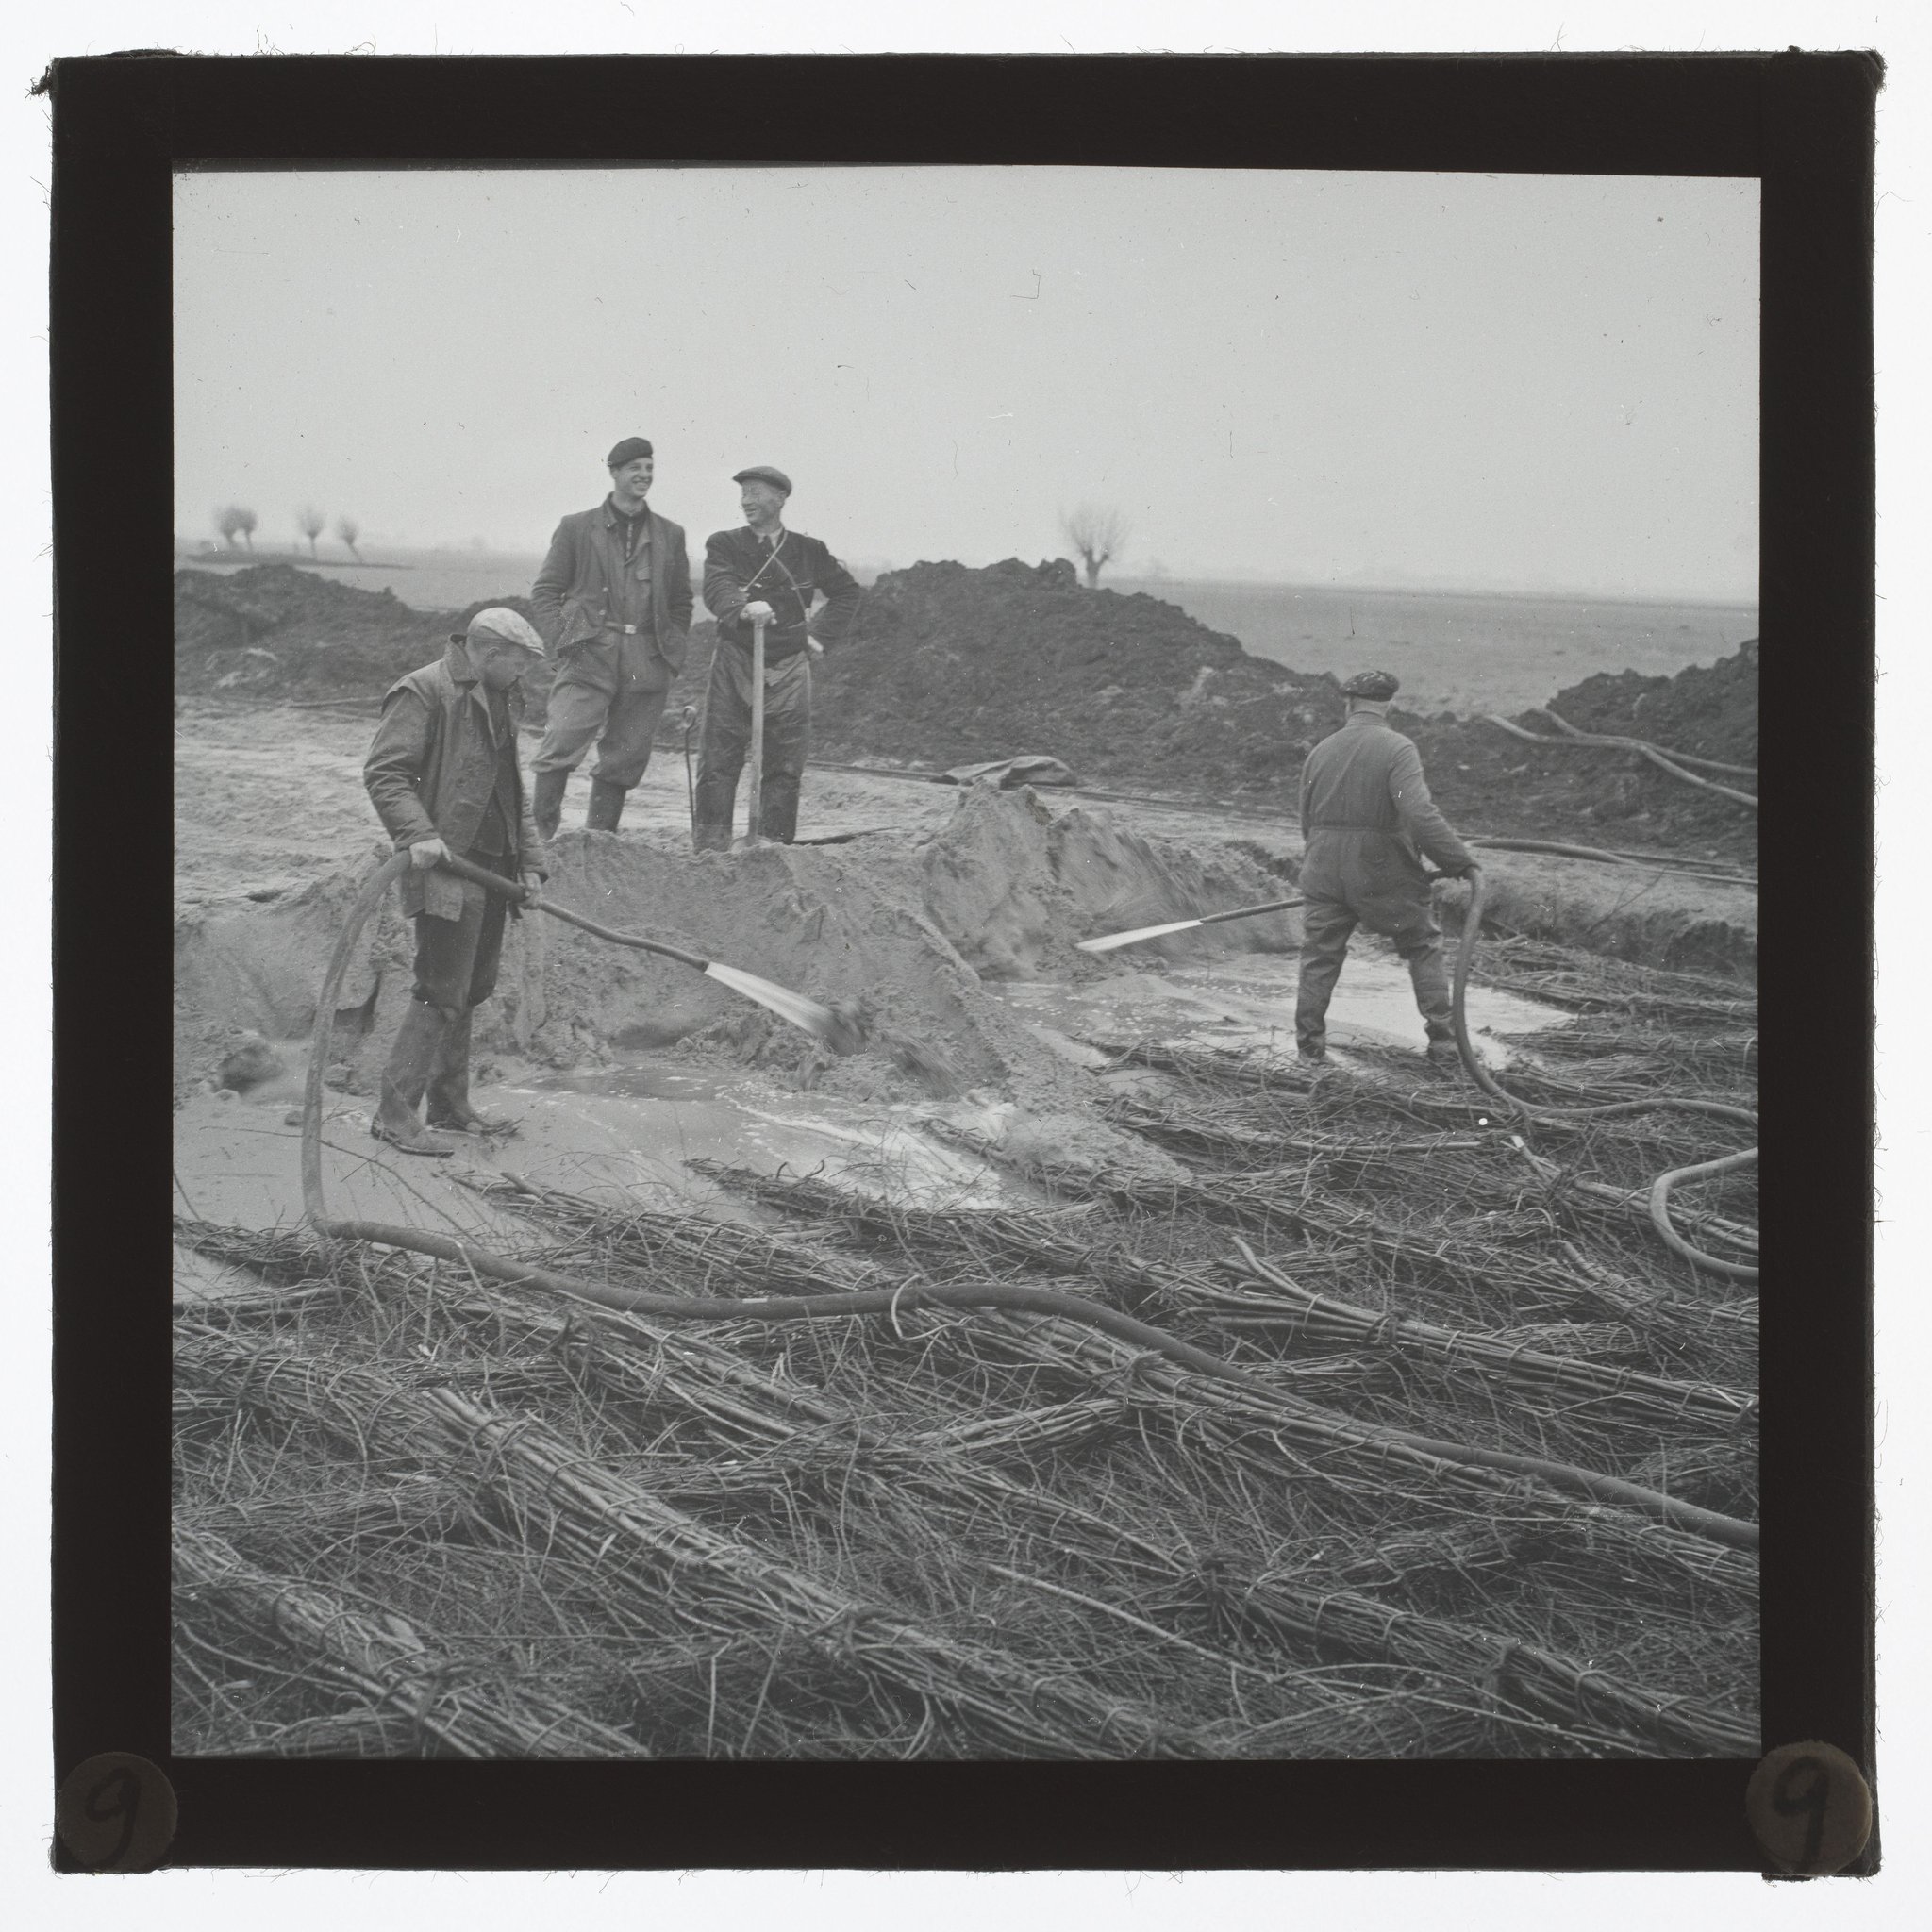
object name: lantern slide photographic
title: Mannen bij een weg in aanbouw, Zuid-Holland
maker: Anonymous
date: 1956-1960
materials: glass, paper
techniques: gelatin silver transparency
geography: south holland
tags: laying the foundations; trench, public road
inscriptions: number: ‘9’